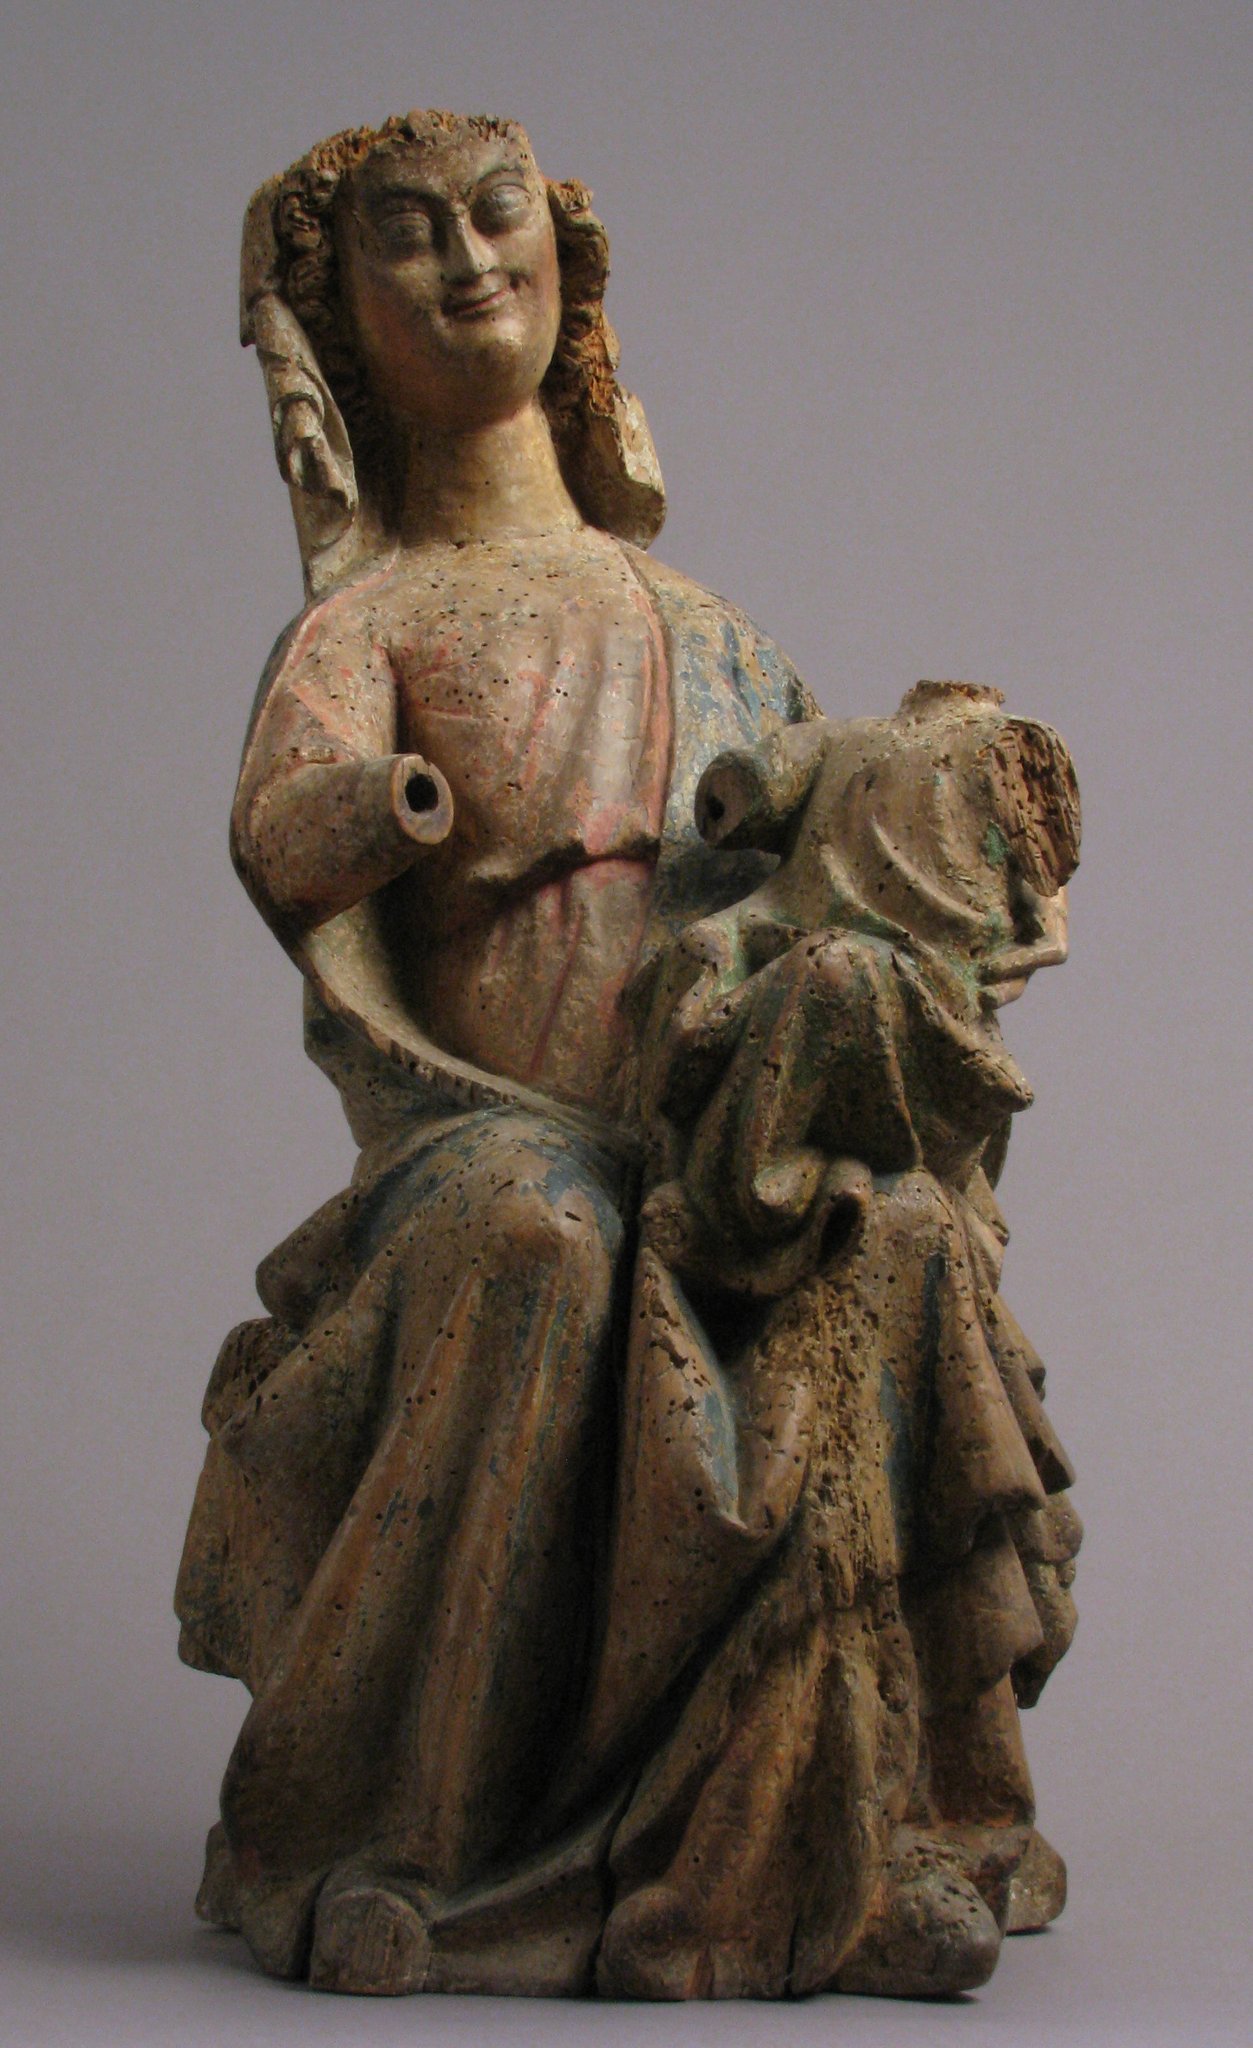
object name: statuette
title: Virgin and Child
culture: french or german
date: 1275-1325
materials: wood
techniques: polychromy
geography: germany